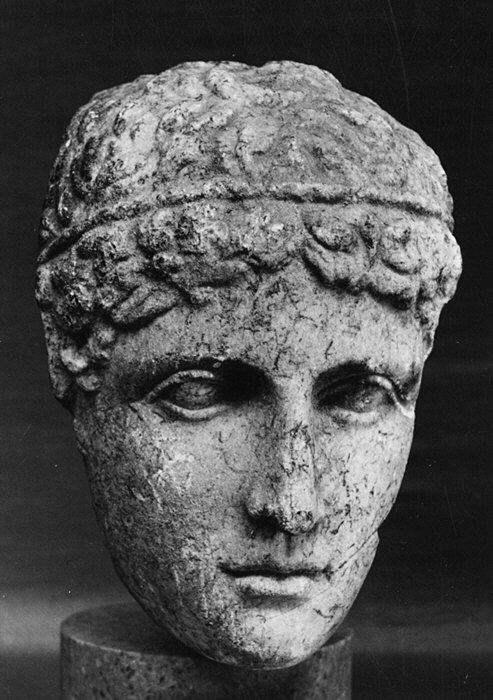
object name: head of a youth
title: Marble statue head of a youth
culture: roman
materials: marble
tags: heads,men